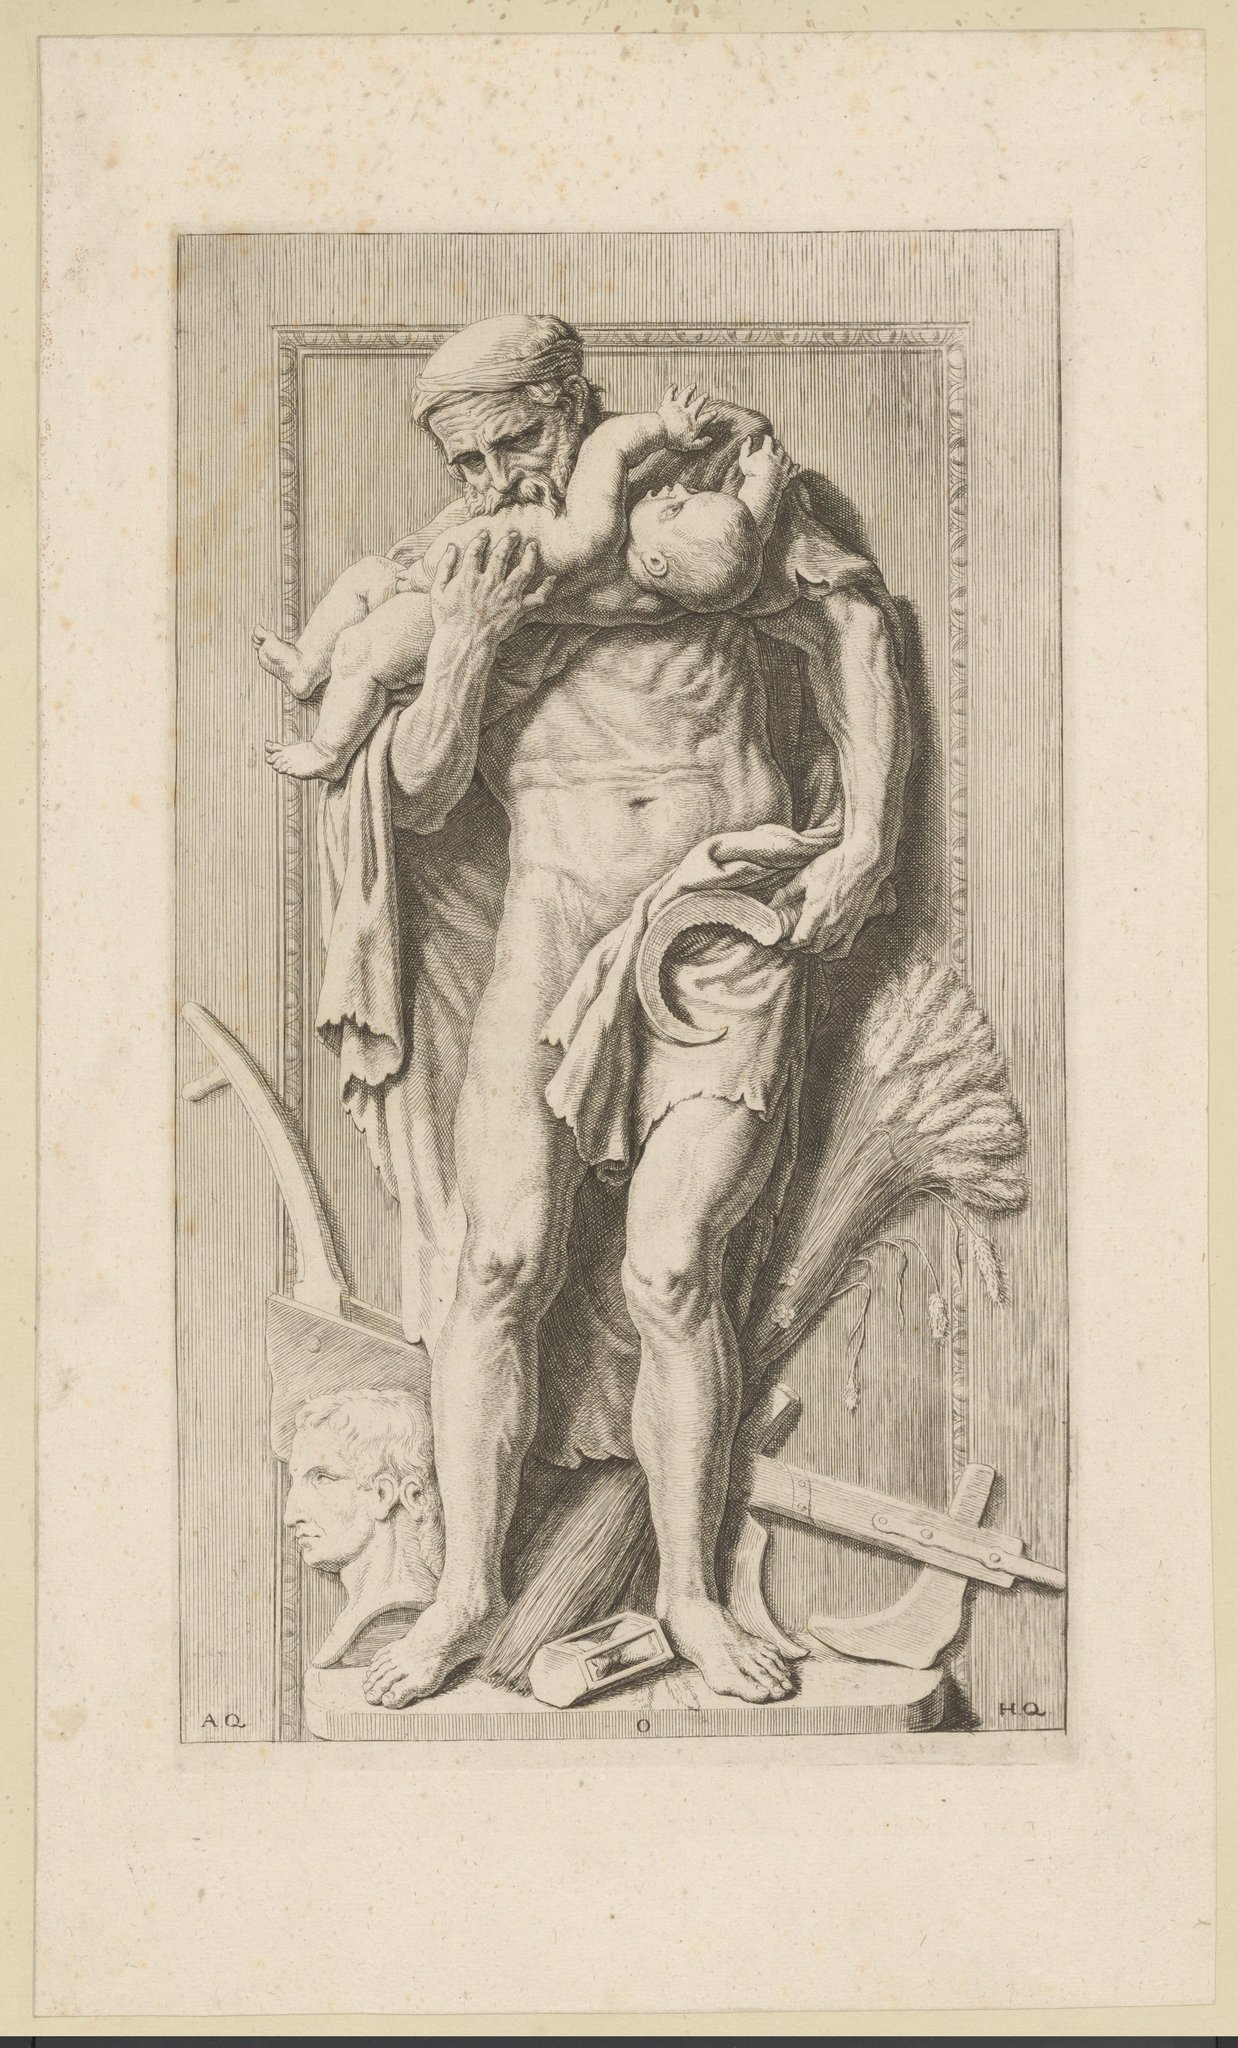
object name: print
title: Beeld van Saturnus in de noordelijke galerij van het Stadhuis op de Dam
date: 1655-1665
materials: paper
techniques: engraving, etching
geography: amsterdam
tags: (story of) saturn (cronus) - attributes, (story of) saturn (cronus), saturn devouring his children, townhall, janus' head, two-faced head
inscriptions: collector's mark: ‘16,23’ Lugt 1641b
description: Prent gebruikt in: Prima pars. Praecipuarum effigierum ac ornamentorum, amplissimae Curiae Amstelrodamensis (…) / Het eerste deel. Van de voornaemste Statuen ende Ciraten, vant konstijck Stadhuys van Amstelredam, tmeeste in marmer gemaeckt, door Artus Quellinus, Beelthouwer der voorseyde Stadt / La Premier Partie. De plusieurs Figures et ornements, de la Maison de Ville d'Amsterdam (…). Amsterdam: Artus Quellinus (I), 1655. Zie RP-P-AO-22-1-1 voor bijhorende titelpagina. Zie RP-P-AO-22-1-2 voor bijhorend register. Zie RP-P-AO-22-1A, RP-P-AO-22-1B, RP-P-AO-22-1C, RP-P-AO-22-1D-1, RP-P-AO-22-1D-2, RP-P-AO-22-1E, RP-P-AO-22-1F, RP-P-AO-22-1G, RP-P-AO-22-1H, RP-P-AO-22-1I, RP-P-AO-22-1K-1, RP-P-AO-22-1K-2, RP-P-AO-22-1K-3, RP-P-AO-22-1K-4, RP-P-AO-22-1K-5, RP-P-AO-22-1L-1, RP-P-AO-22-1L-2, RP-P-AO-22-1M-1, RP-P-AO-22-1M-2, RP-P-AO-22-1N-1, RP-P-AO-22-1N-2, RP-P-AO-22-1N-3, RP-P-AO-22-1N-4, RP-P-AO-22-1N-5, RP-P-AO-22-1O-2, RP-P-AO-22-1O-3, RP-P-AO-22-1O-4, RP-P-AO-22-1P-1, RP-P-AO-22-1P-2, RP-P-AO-22-1P-3, RP-P-AO-22-1P-4, RP-P-AO-22-1Q-1, RP-P-AO-22-1Q-2, RP-P-AO-22-1Q-3, RP-P-AO-22-1Q-4, RP-P-AO-22-1R-1, RP-P-AO-22-1R-2, RP-P-AO-22-1R-3, RP-P-AO-22-1R-4, RP-P-AO-22-1R-5, RP-P-AO-22-1S-1, RP-P-AO-22-1S-2, RP-P-AO-22-1S-3, RP-P-AO-22-1S-4, RP-P-AO-22-1S-5, RP-P-AO-22-1T-1 en RP-P-AO-22-1T-2 voor andere prenten uit deze publicatie. Zelfde staat van prent ook gebruikt in: Prima pars. Praecipuarum effigierum ac ornamentorum, amplissimae Curiae Amstelrodamensis (…) / Het eerste deel. Van de voornaemste Statuen ende Ciraten, vant konstijck Stadhuys van Amstelredam, tmeeste in marmer gemaeckt, door Artus Quellinus, Beelthouwer der voorseyde Stadt / La Premier Partie. De plusieurs Figures et ornements, de la Maison de Ville d'Amsterdam (…). Amsterdam: Frederik de Wit, 1665. Latere staat van prent ook gebruikt in: Architecture peinture et sculpture de la Maison de Ville d'Amsterdam, representee en CIX. figures en taille-douce (…). Amsterdam: David Mortier, 1719. En in: Architecture peinture et sculpture de la Maison de Ville d'Amsterdam, representee en CIX. figures en taille-douce (…). Amsterdam: Gerard Valck, 1719. En in: Bouw schilder en beeldhouwkonst, van het Stadhuis te Amsteldam, vertoont in CIX figuuren (…). Amsterdam: Covens & Mortier & Covens Jr., s.a. (1774-1783). Zie BK-AM-51-13 voor model van beeld.